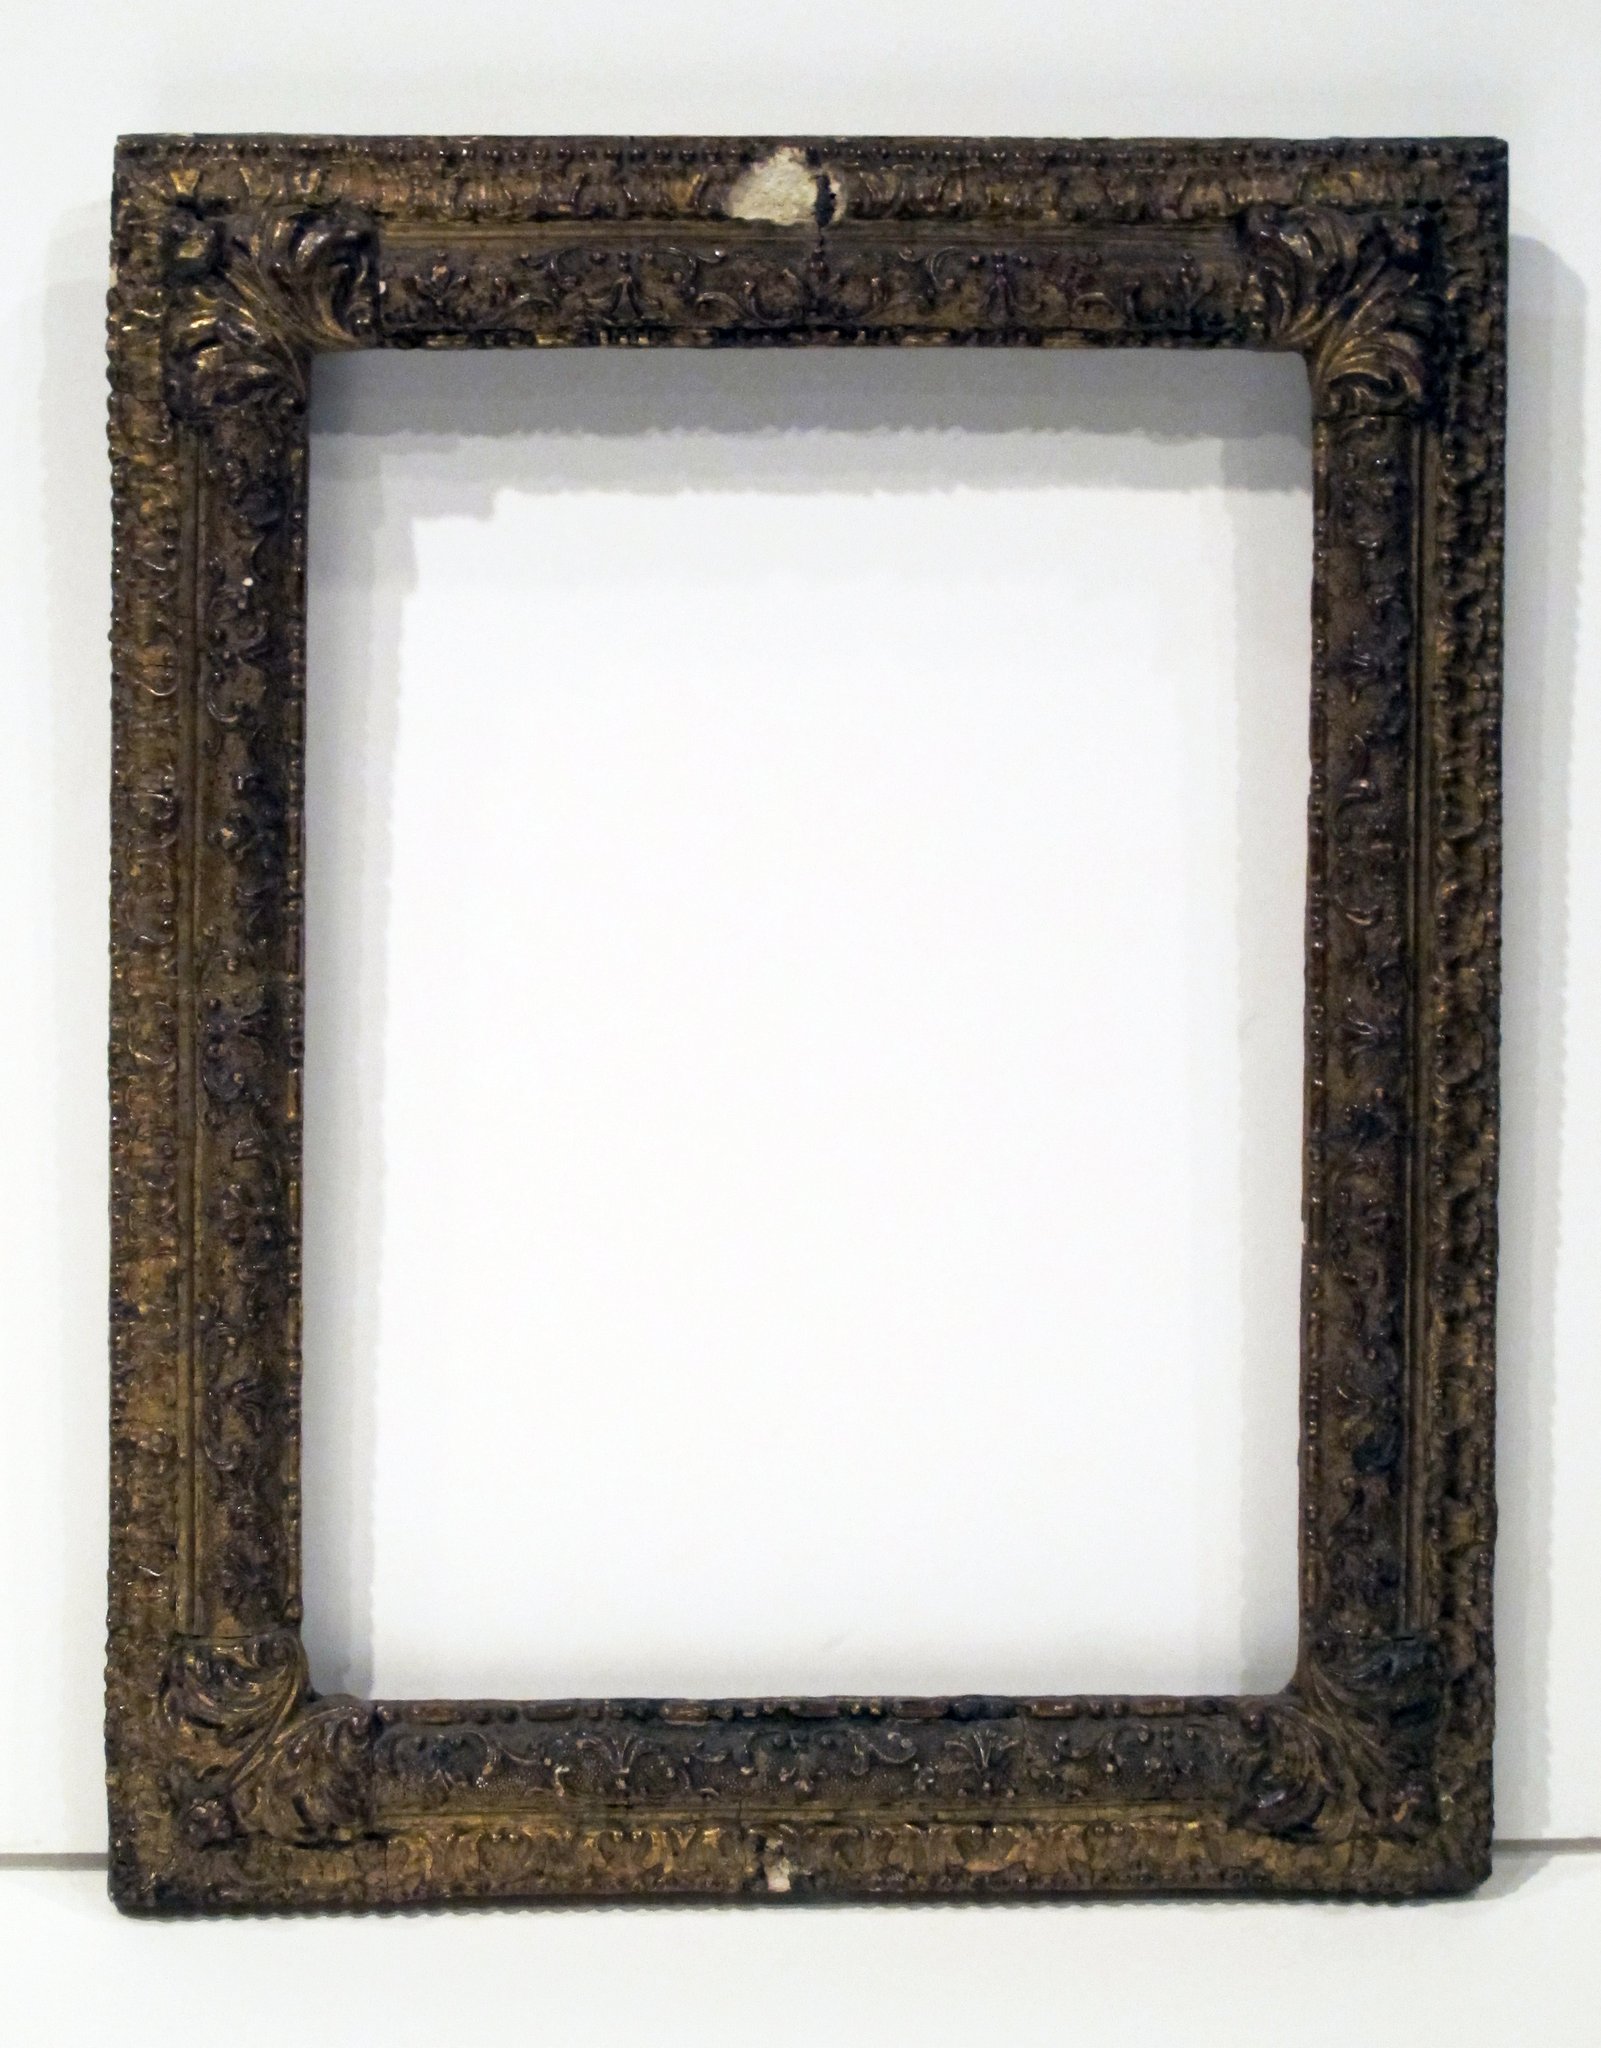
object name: frame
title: Single swept frame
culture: french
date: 1767-1800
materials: wood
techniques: carving, gilding